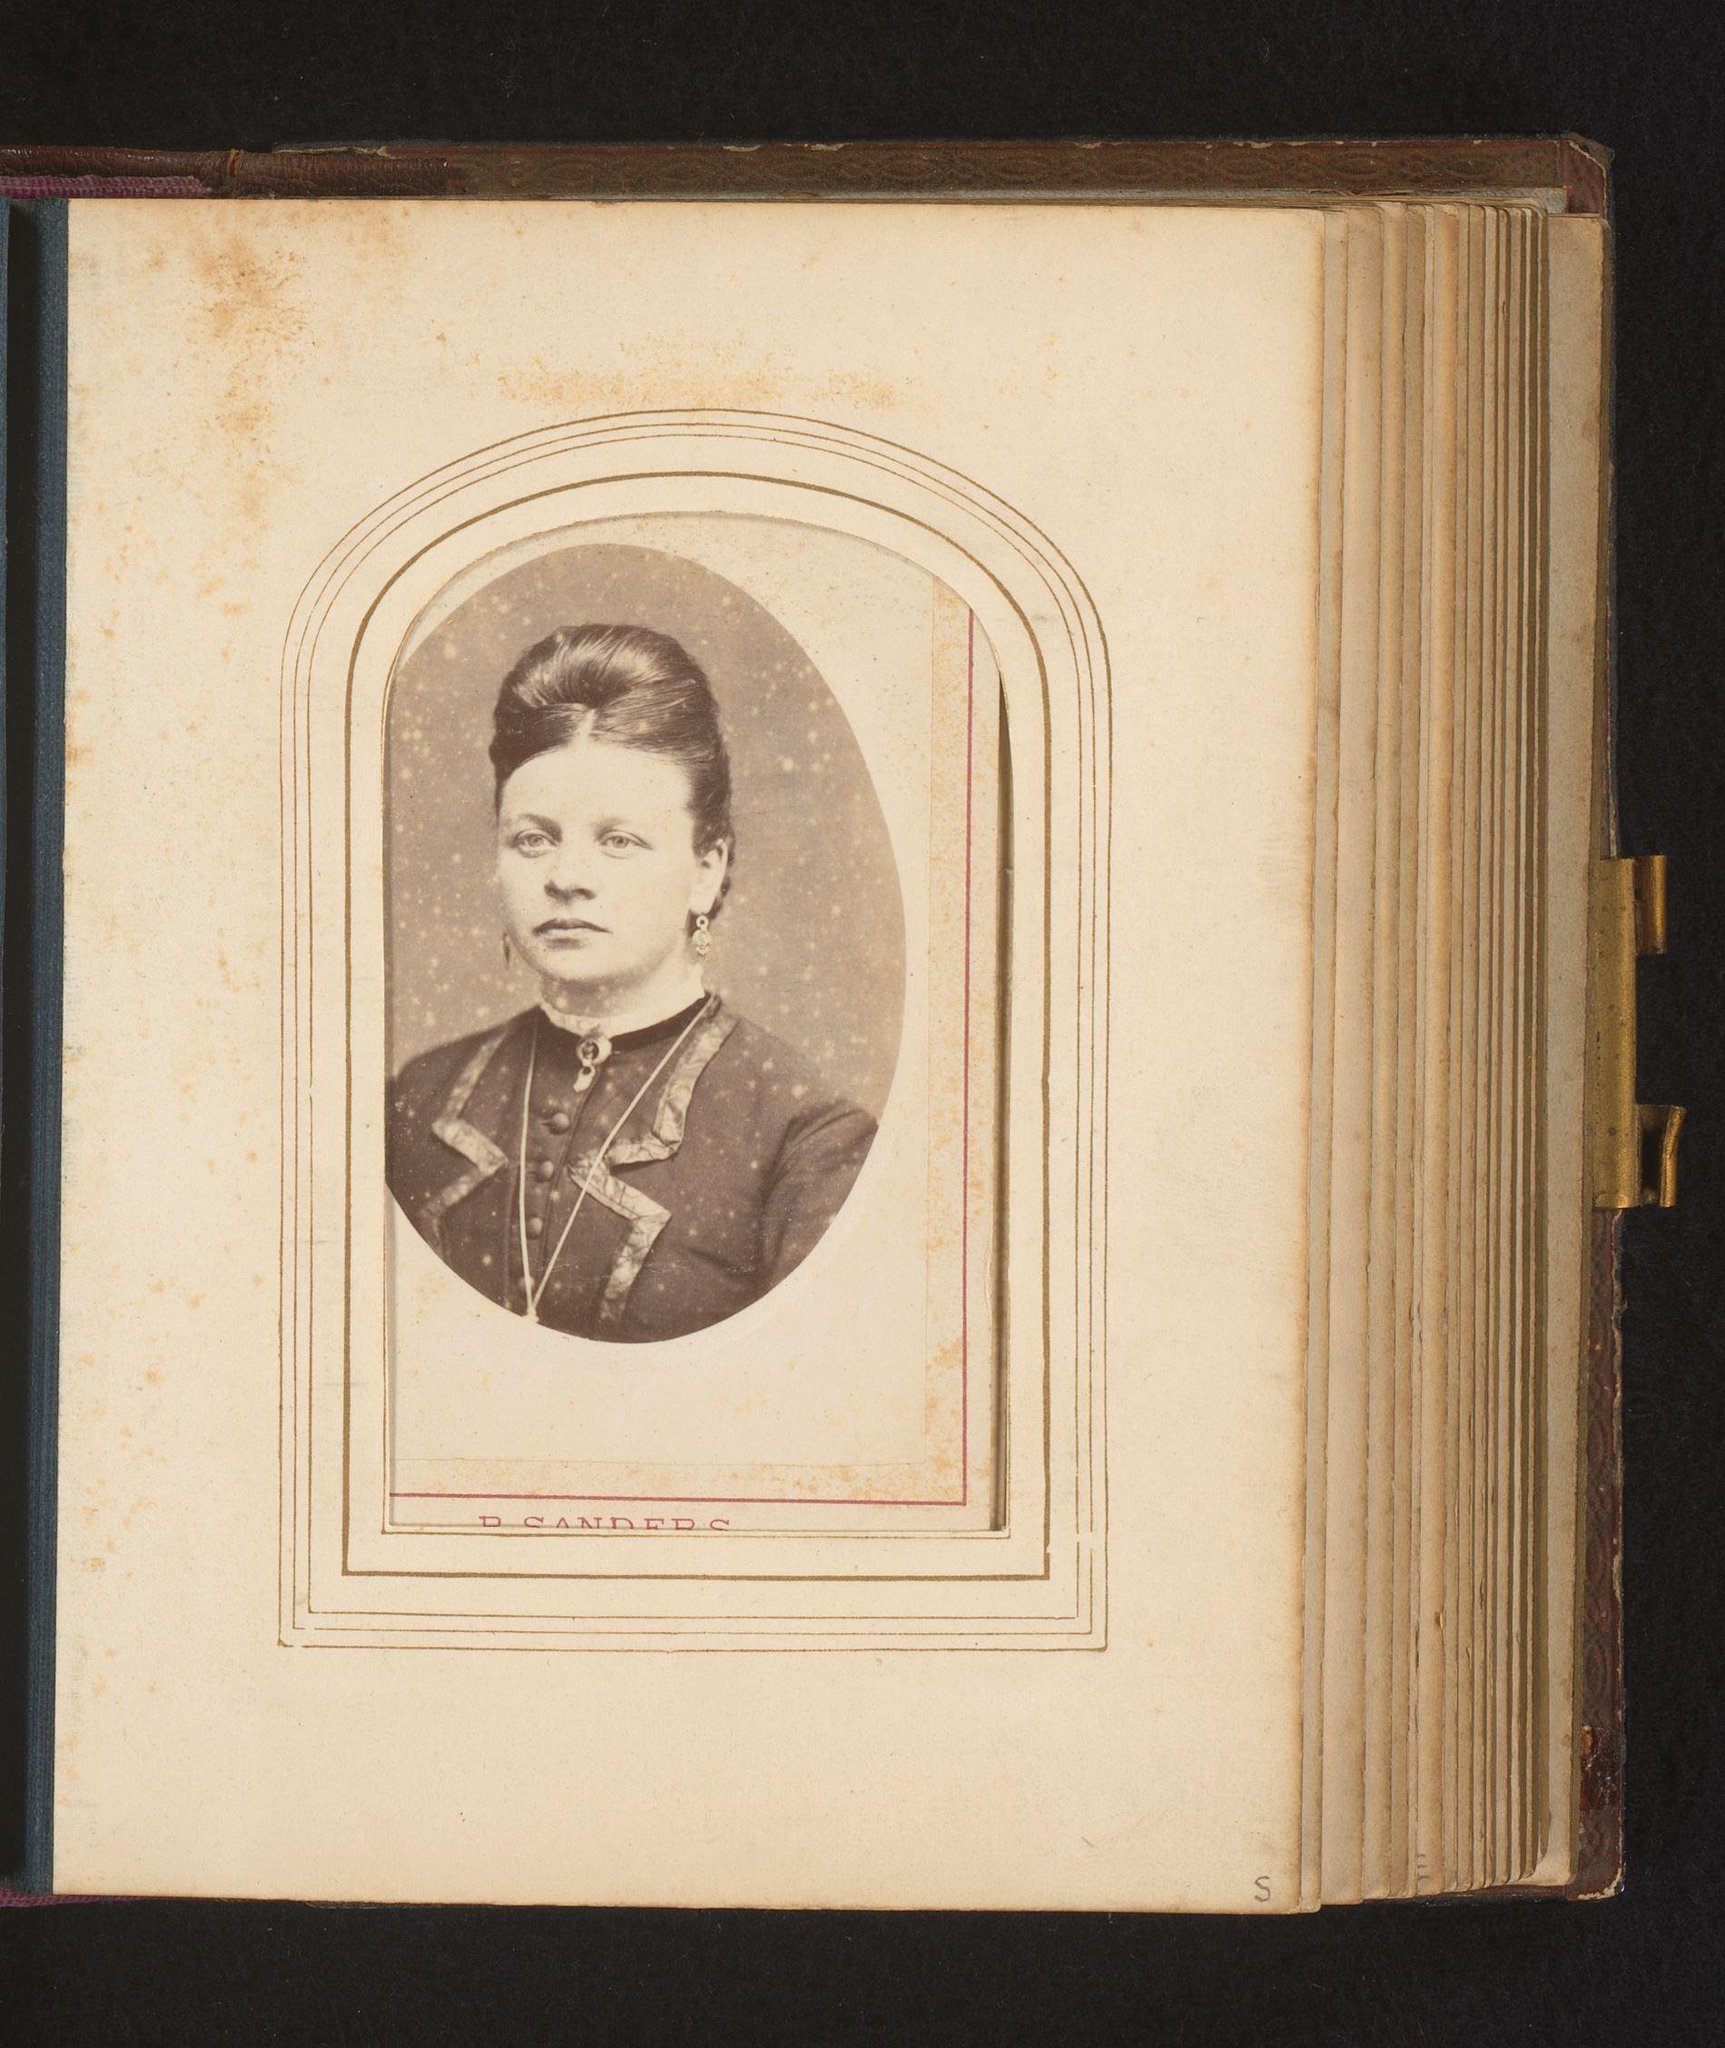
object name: carte de visite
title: Portret van een vrouw met lange halsketting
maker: benjamin sanders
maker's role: fotograaf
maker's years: 1841-1889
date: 1856-1889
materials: cardboard, photographic support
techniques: albumen print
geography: groningen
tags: historical persons - bb - woman, necklace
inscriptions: inscription: ‘B. Sanders/ Photographe/ Groningen/ Nieuwe Ebbingestraat./ Deze Portretten kunnen/ steeds nabesteld worden.’